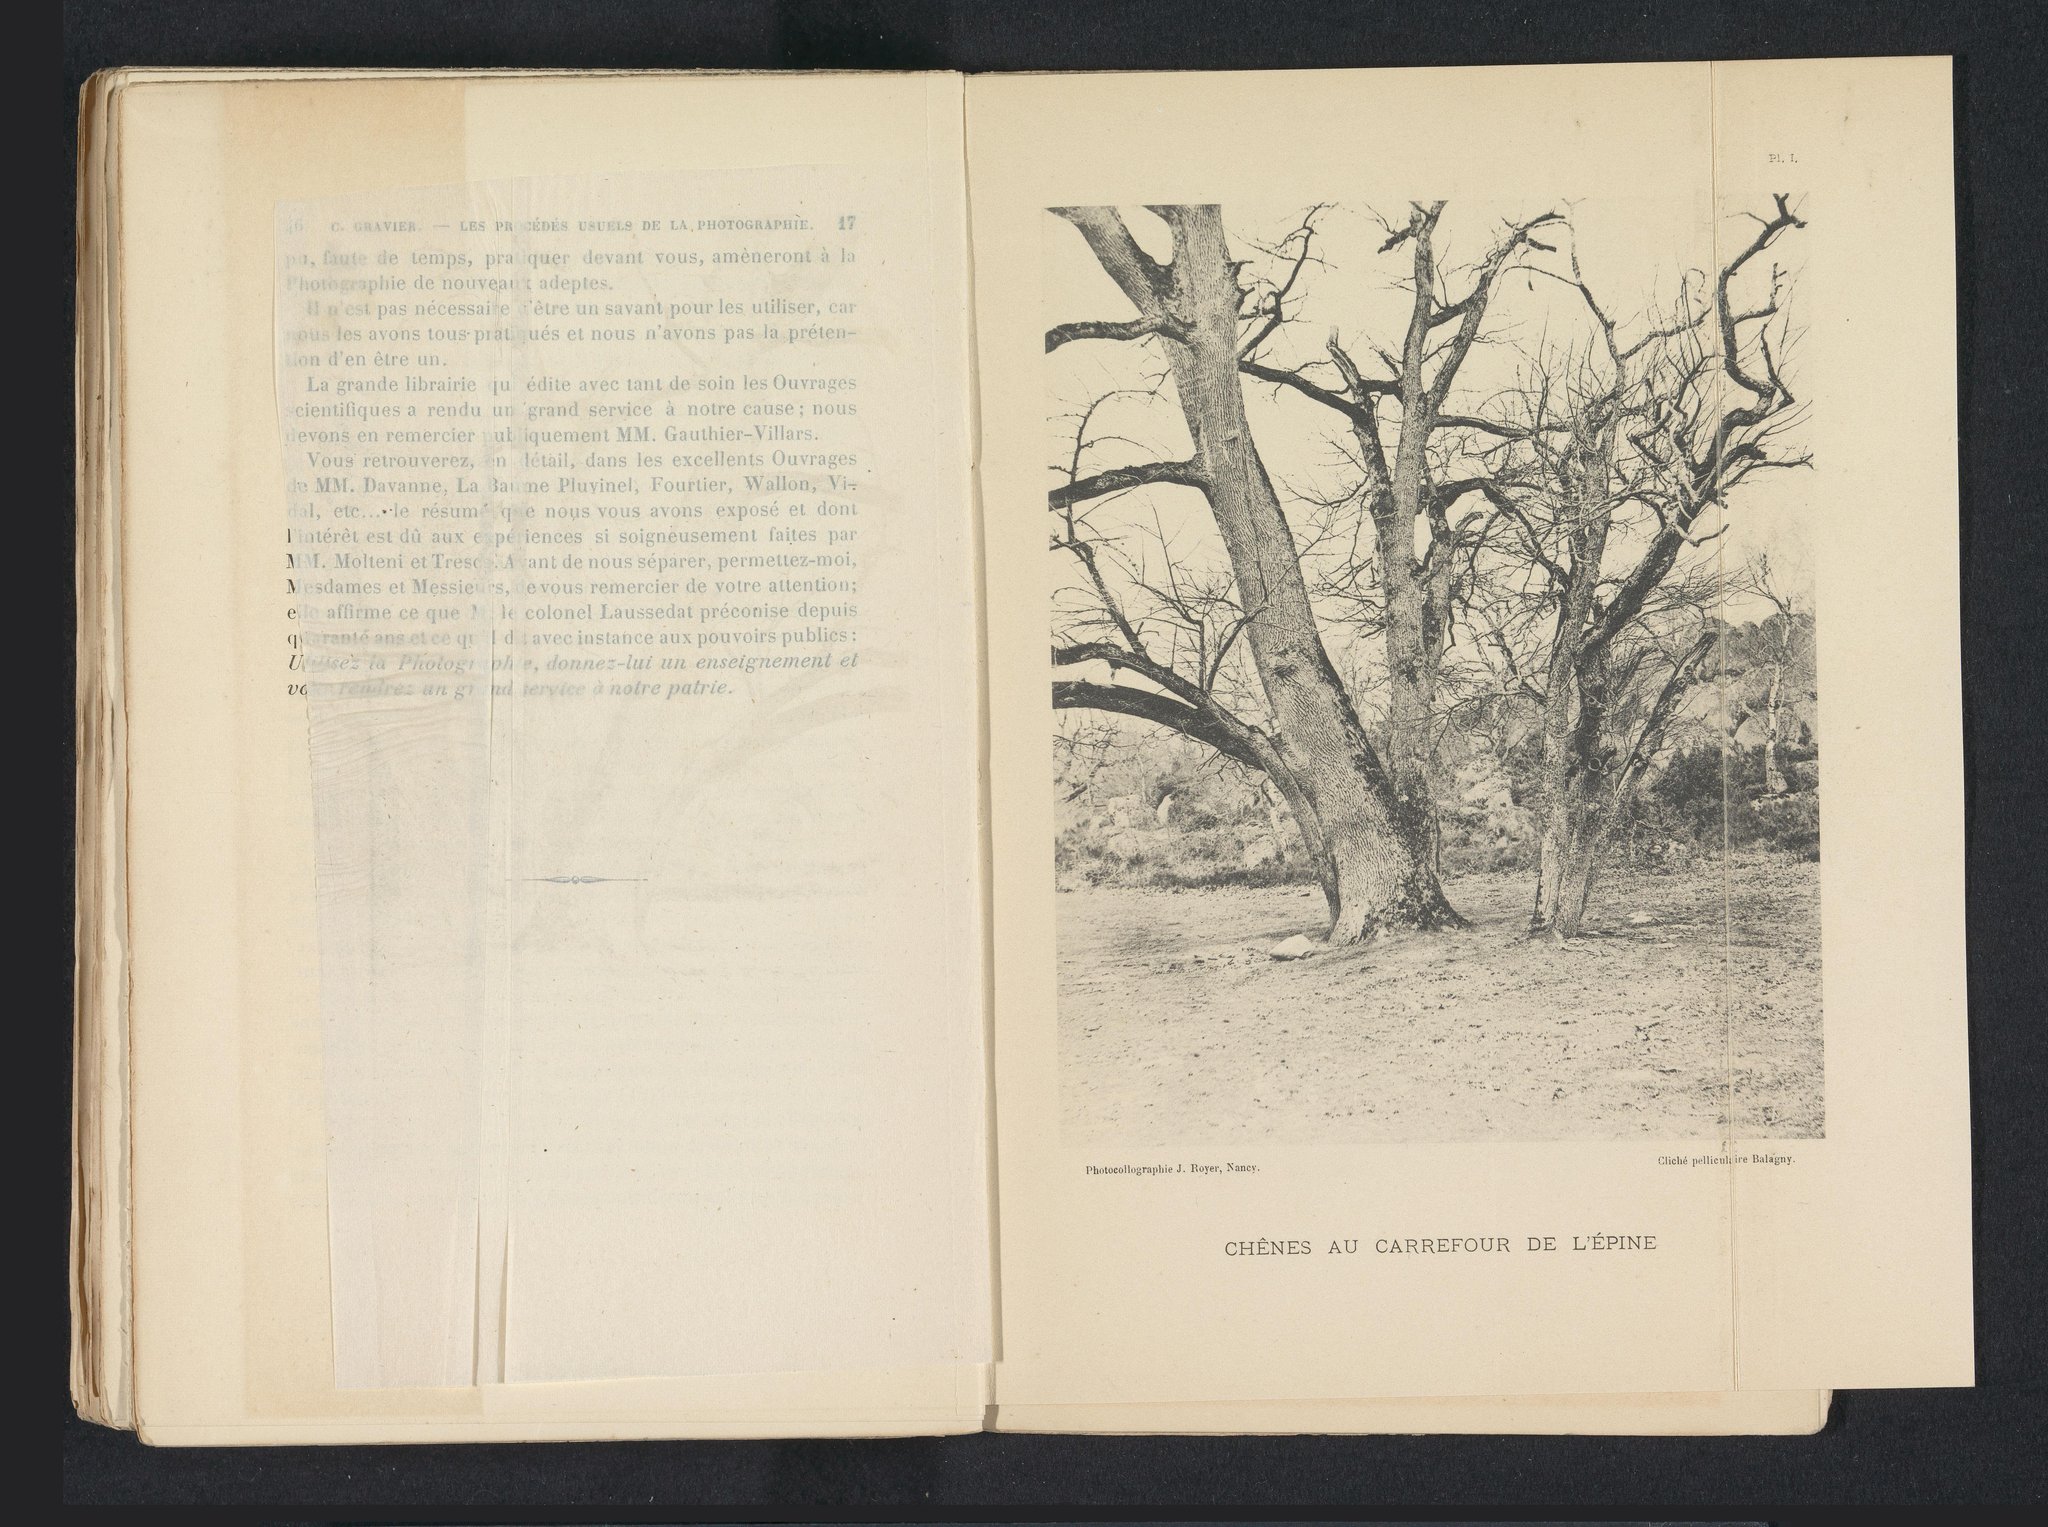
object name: photomechanical print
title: Chènes au carrefour de l'épine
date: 1883-1893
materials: paper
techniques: photograph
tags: trees: oak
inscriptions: number: ‘Pl. I.’